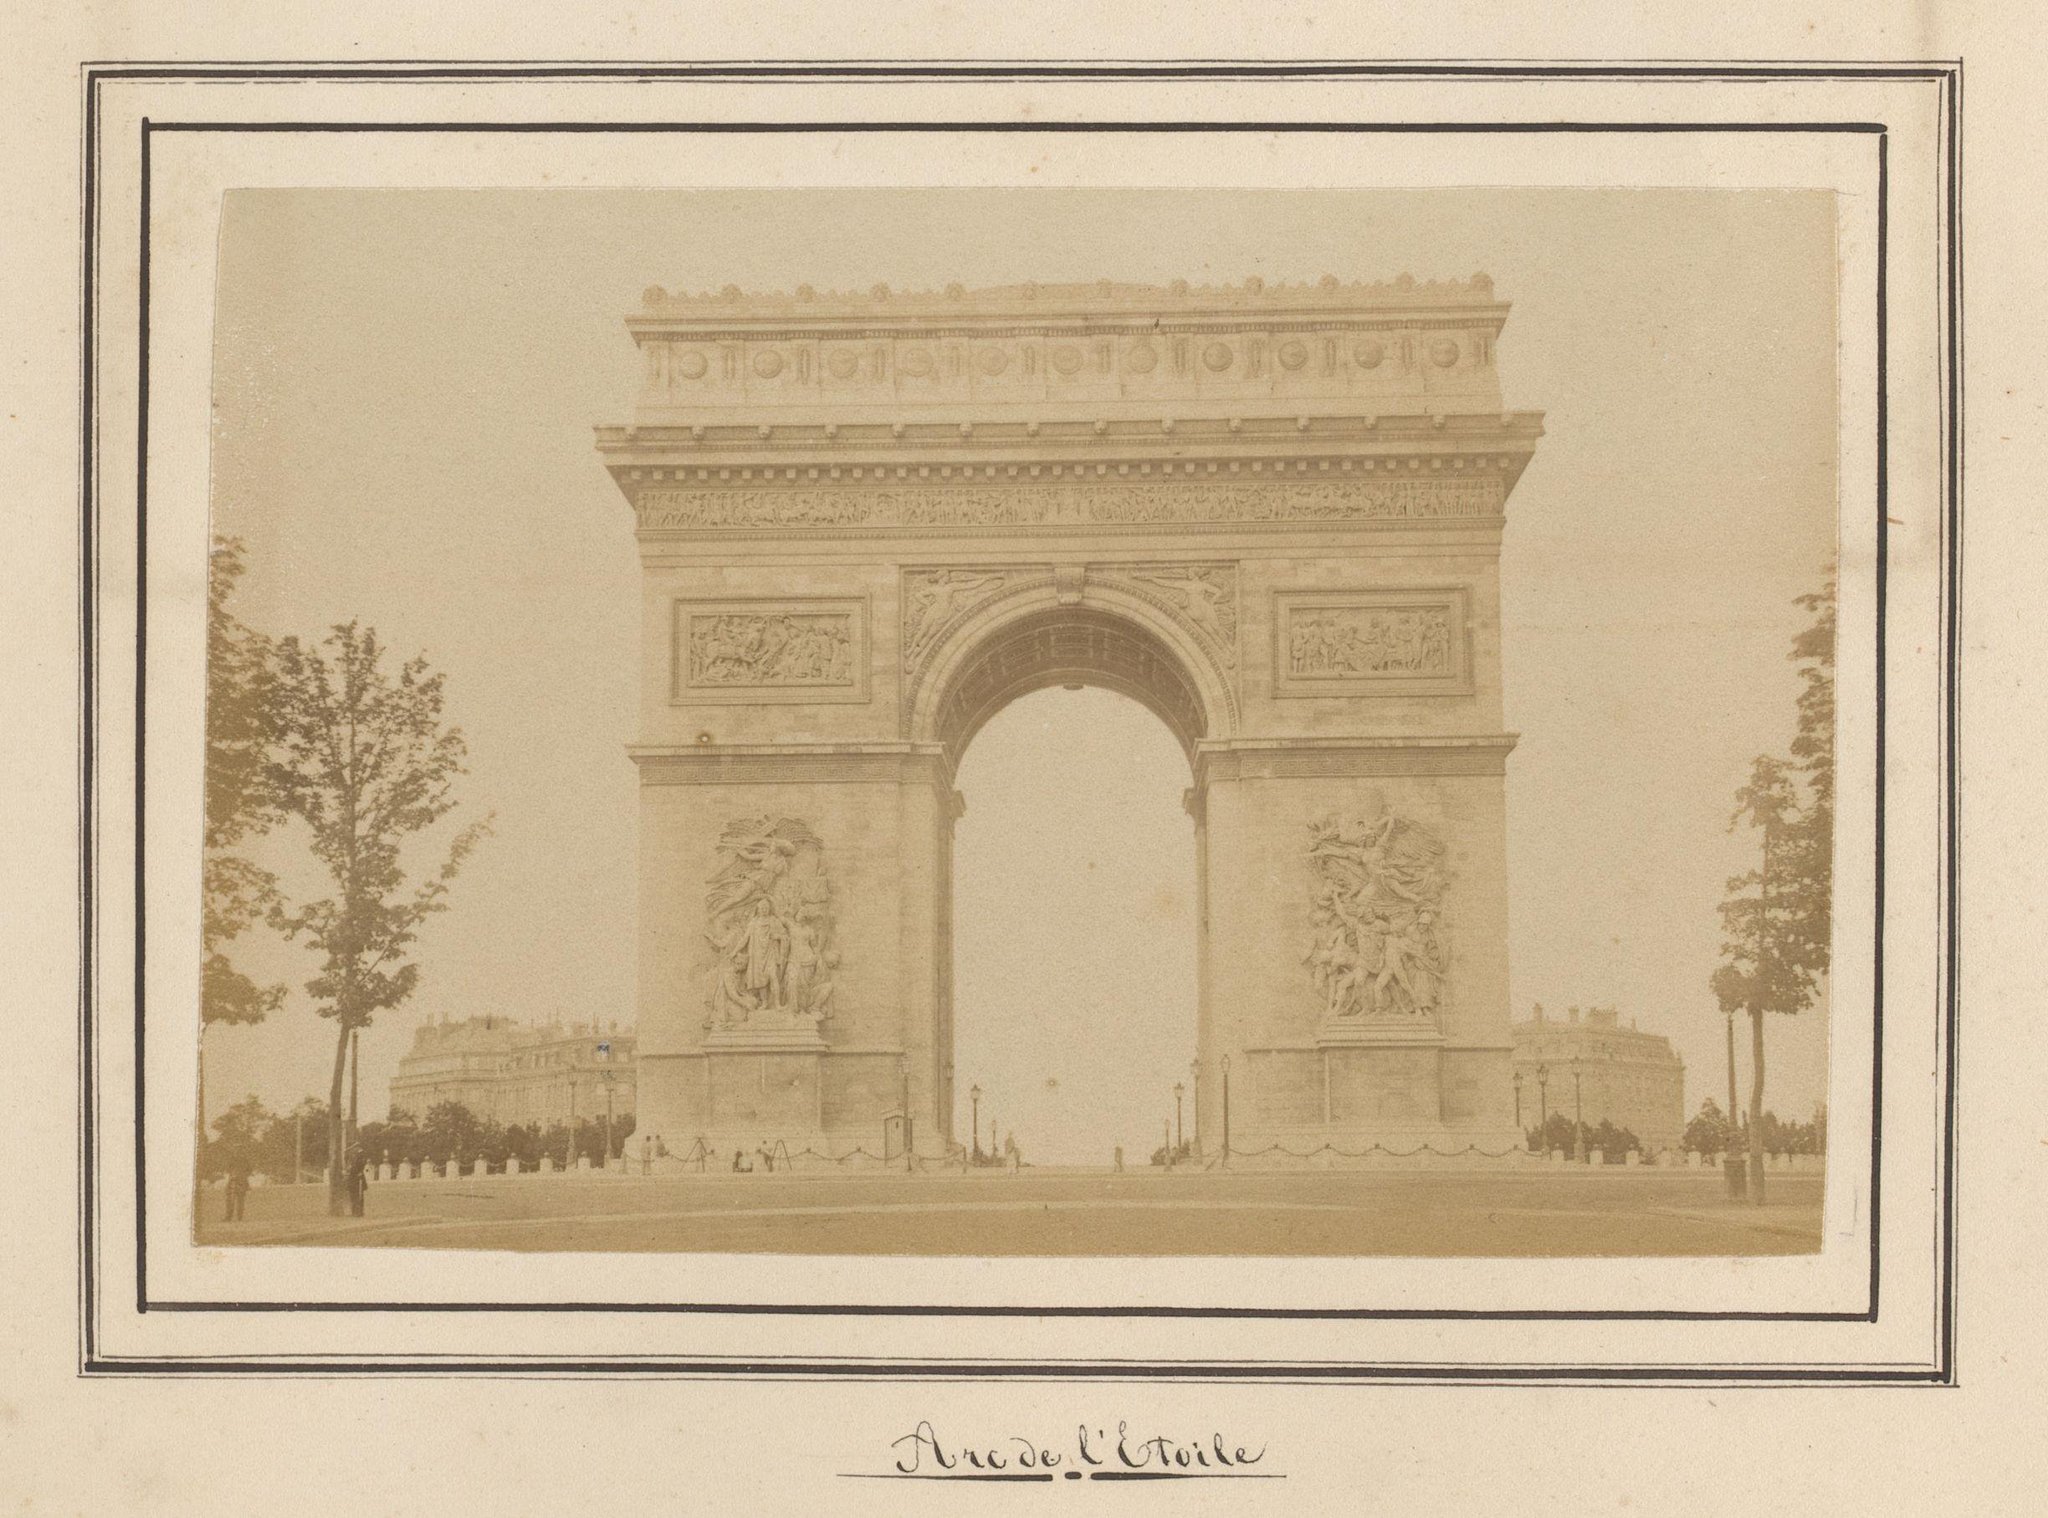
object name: album leaf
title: Arc de l'Etoile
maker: Anonymous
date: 1870-1882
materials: paper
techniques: albumen print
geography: paris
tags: triumphal arch